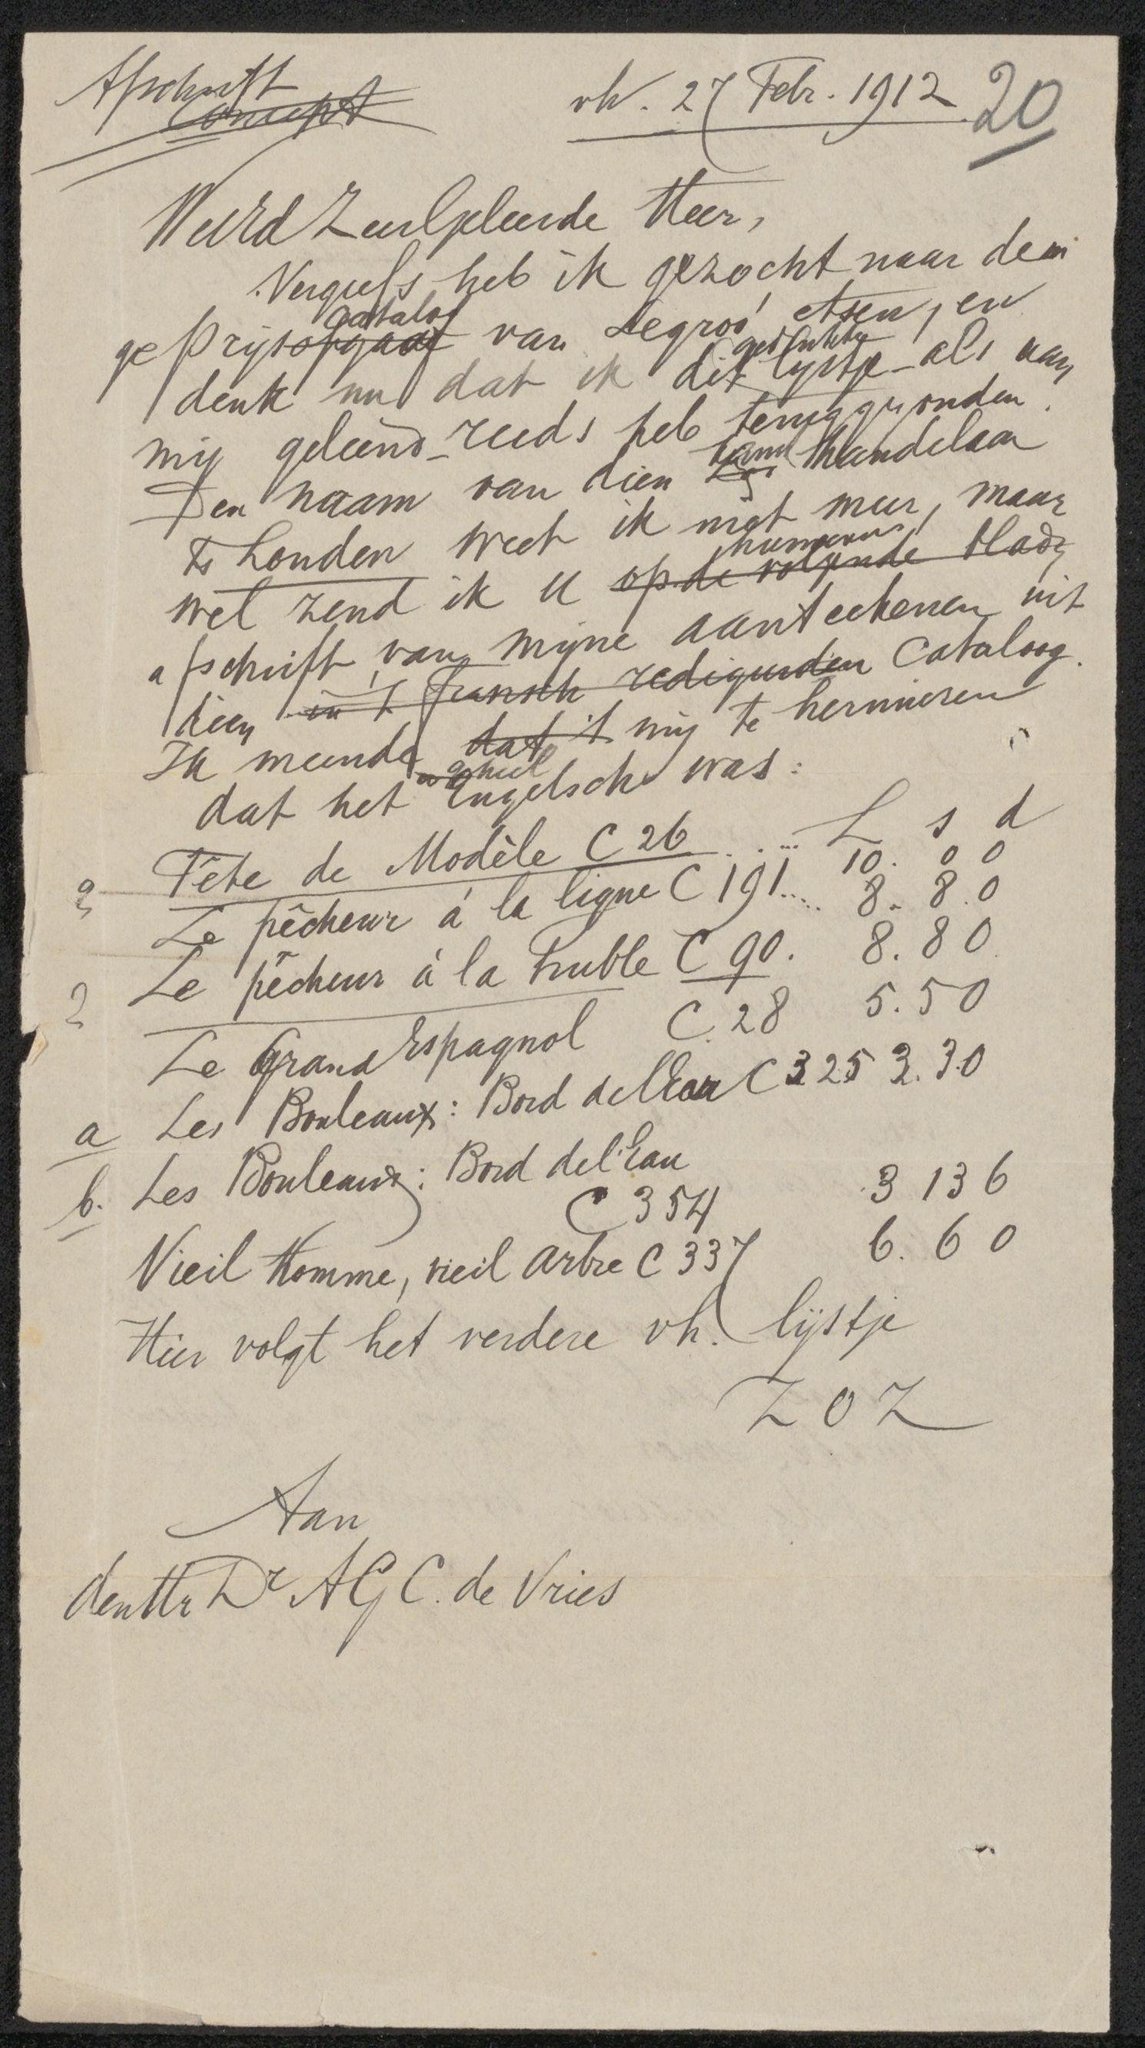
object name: letter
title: Brief aan A.G.C. de Vries (1872-1936)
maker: august allebé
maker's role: draughtsman, print maker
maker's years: 1838-1927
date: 1912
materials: ink, paper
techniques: pen, writing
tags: alphonse legros, paris, print maker, charles meryon, a.g.c. vries (1872-1936), art trade, art shop, the graphic arts, money